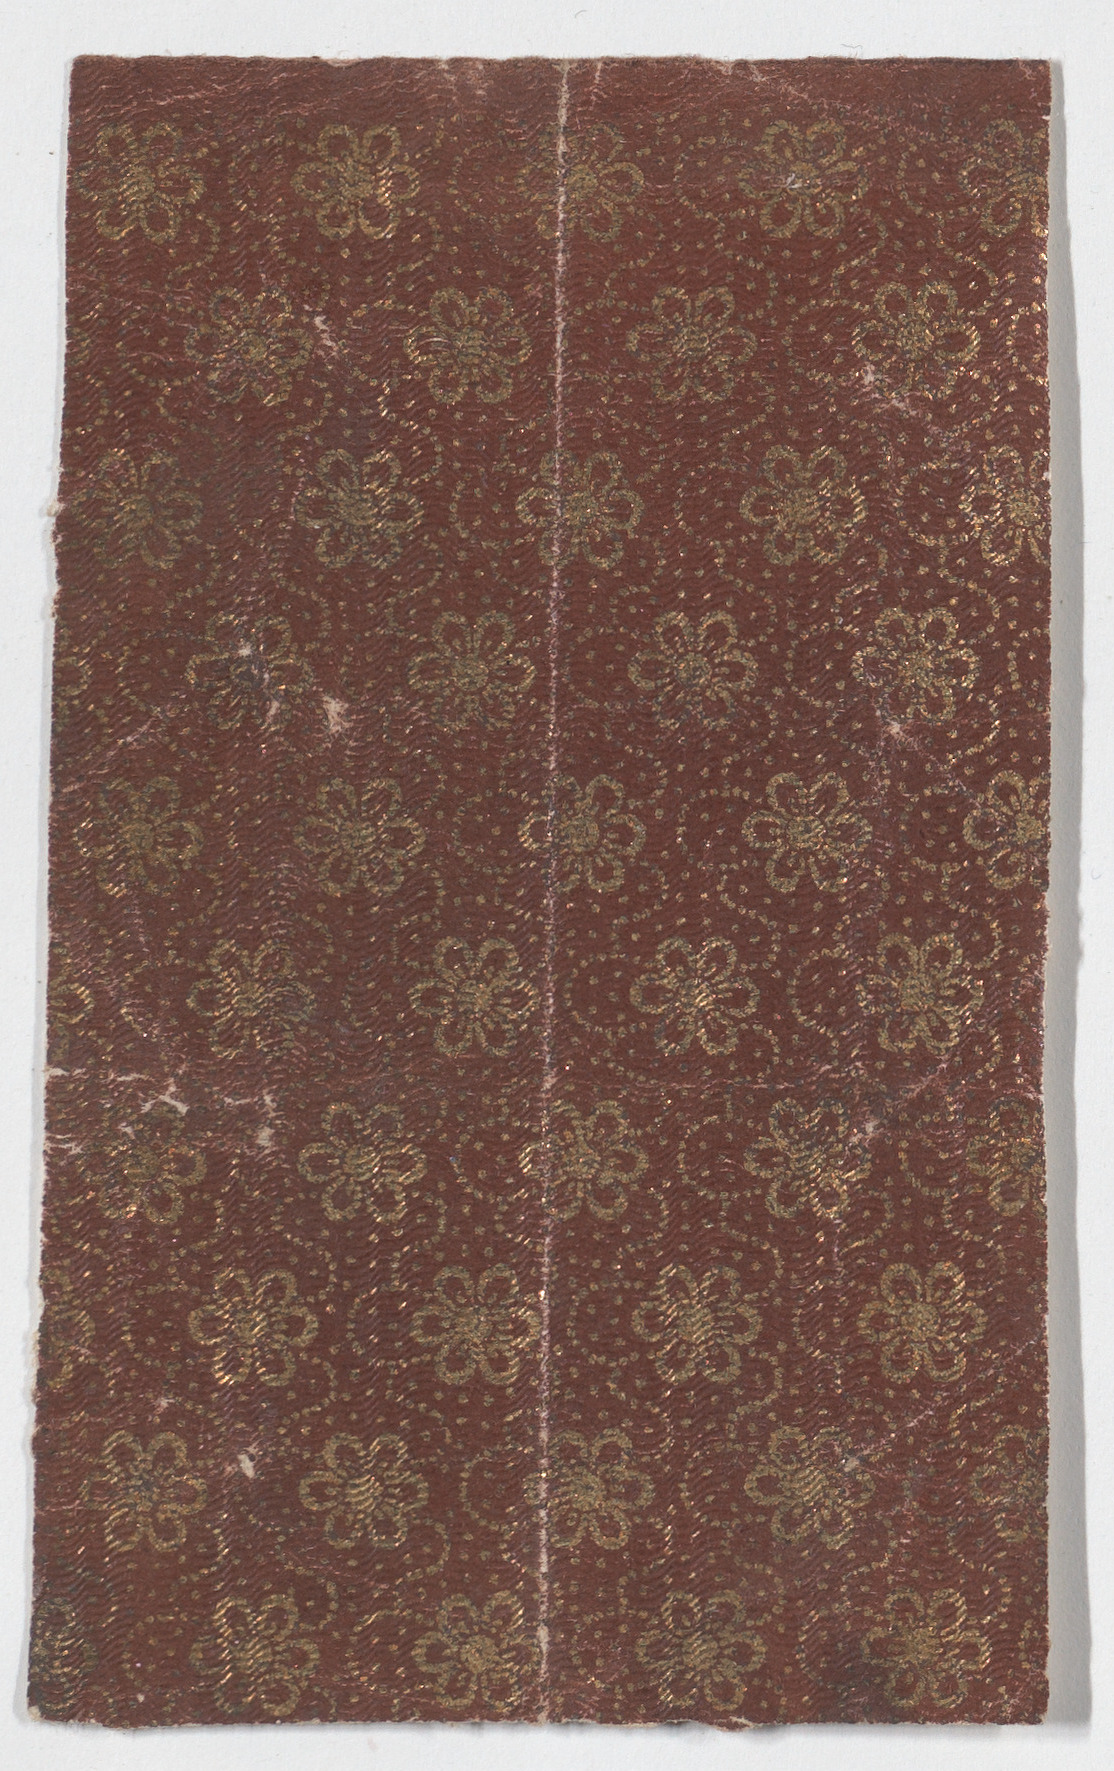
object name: print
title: Sheet with gold floral pattern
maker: Anonymous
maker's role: artist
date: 1801-1900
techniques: relief print